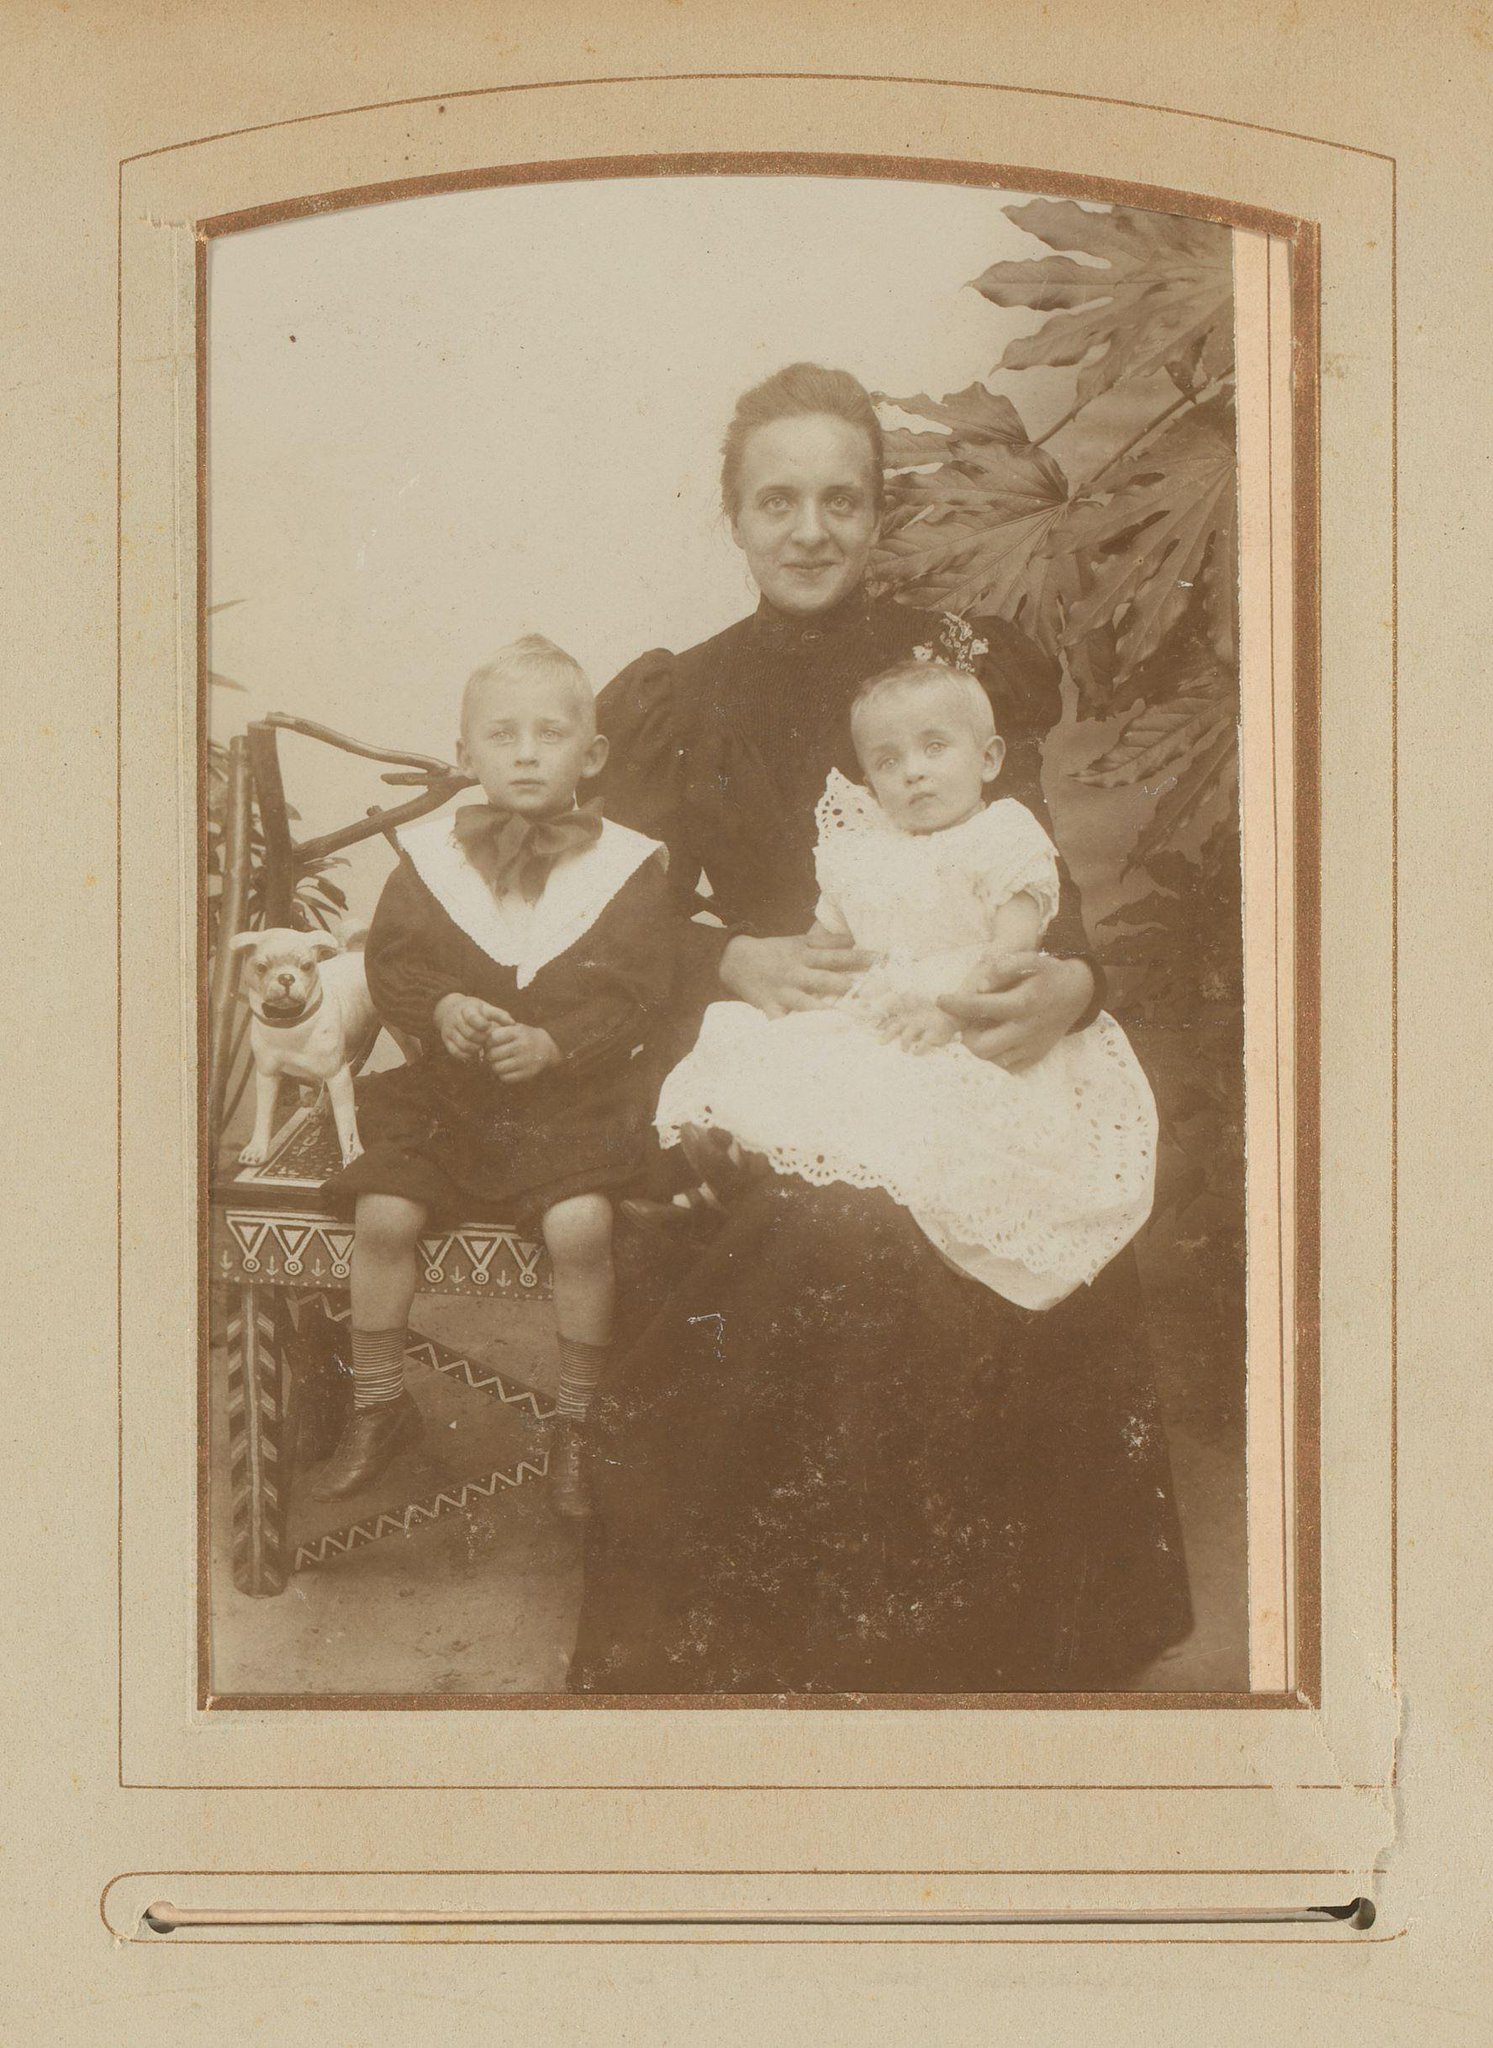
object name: album leaf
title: Portret van een zittende vrouw en twee kinderen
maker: jacobus franciscus louis muller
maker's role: fotograaf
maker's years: 1870-1924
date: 1899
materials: cardboard, photographic support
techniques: collodion silver print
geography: the hague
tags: child (+ two persons), mother and child(ren), woman and child(ren) (family group), anonymous historical persons portrayed in a group, in a group-portrait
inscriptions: date: ‘4 September 1899’, inscription: ‘A. C. CORDES/ Cuijpstraat 55/ DEN HAAG.’